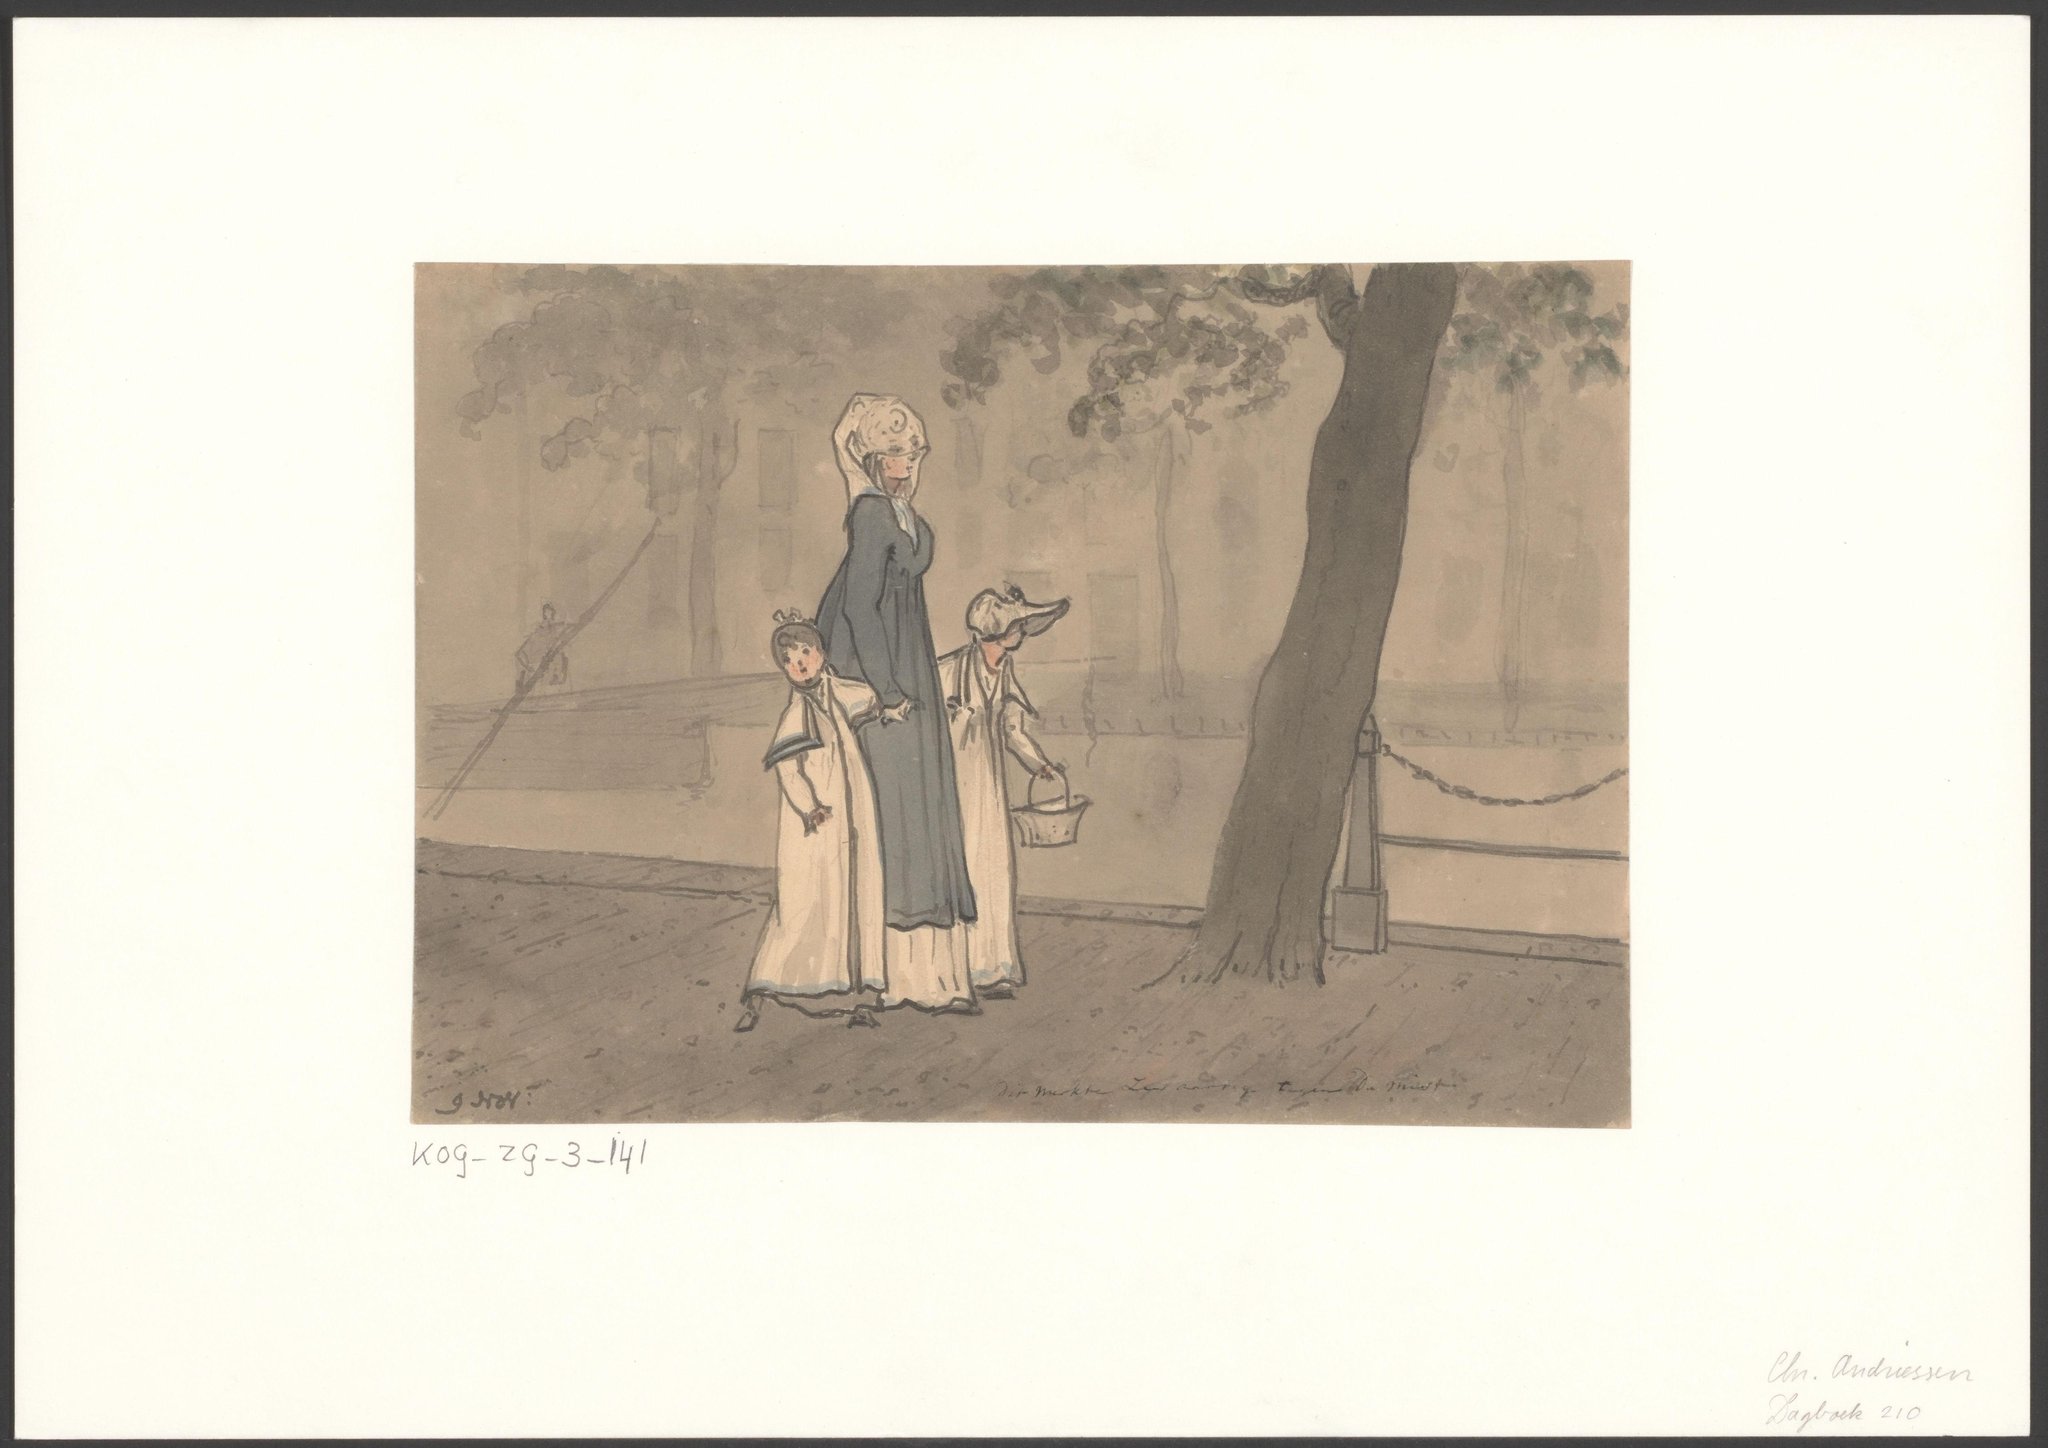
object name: drawing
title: Twee vrouwen in empire kleding, proberen hun schoenen droog te houden in de smeltende sneeuw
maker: christiaan andriessen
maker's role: draughtsman, print maker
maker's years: 1775-1846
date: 1805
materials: ink, paper, pencil, watercolor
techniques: brush, pen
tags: mother with daughter(s) (mother-love), walking, mist, fog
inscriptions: signature: ‘J Andriessen’, inscription: ‘9 nov: dit werkte zeer aardig tegen de mist’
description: Een vrouw, gekleed in een lange mantel met een voile over het hoofd en met twee dochters bij de hand, passeert het huis van de familie Andriessen op de Amstel 95. In het commentaar benoemt Andriessen hoe mooi zij afsteken tegen de mist.